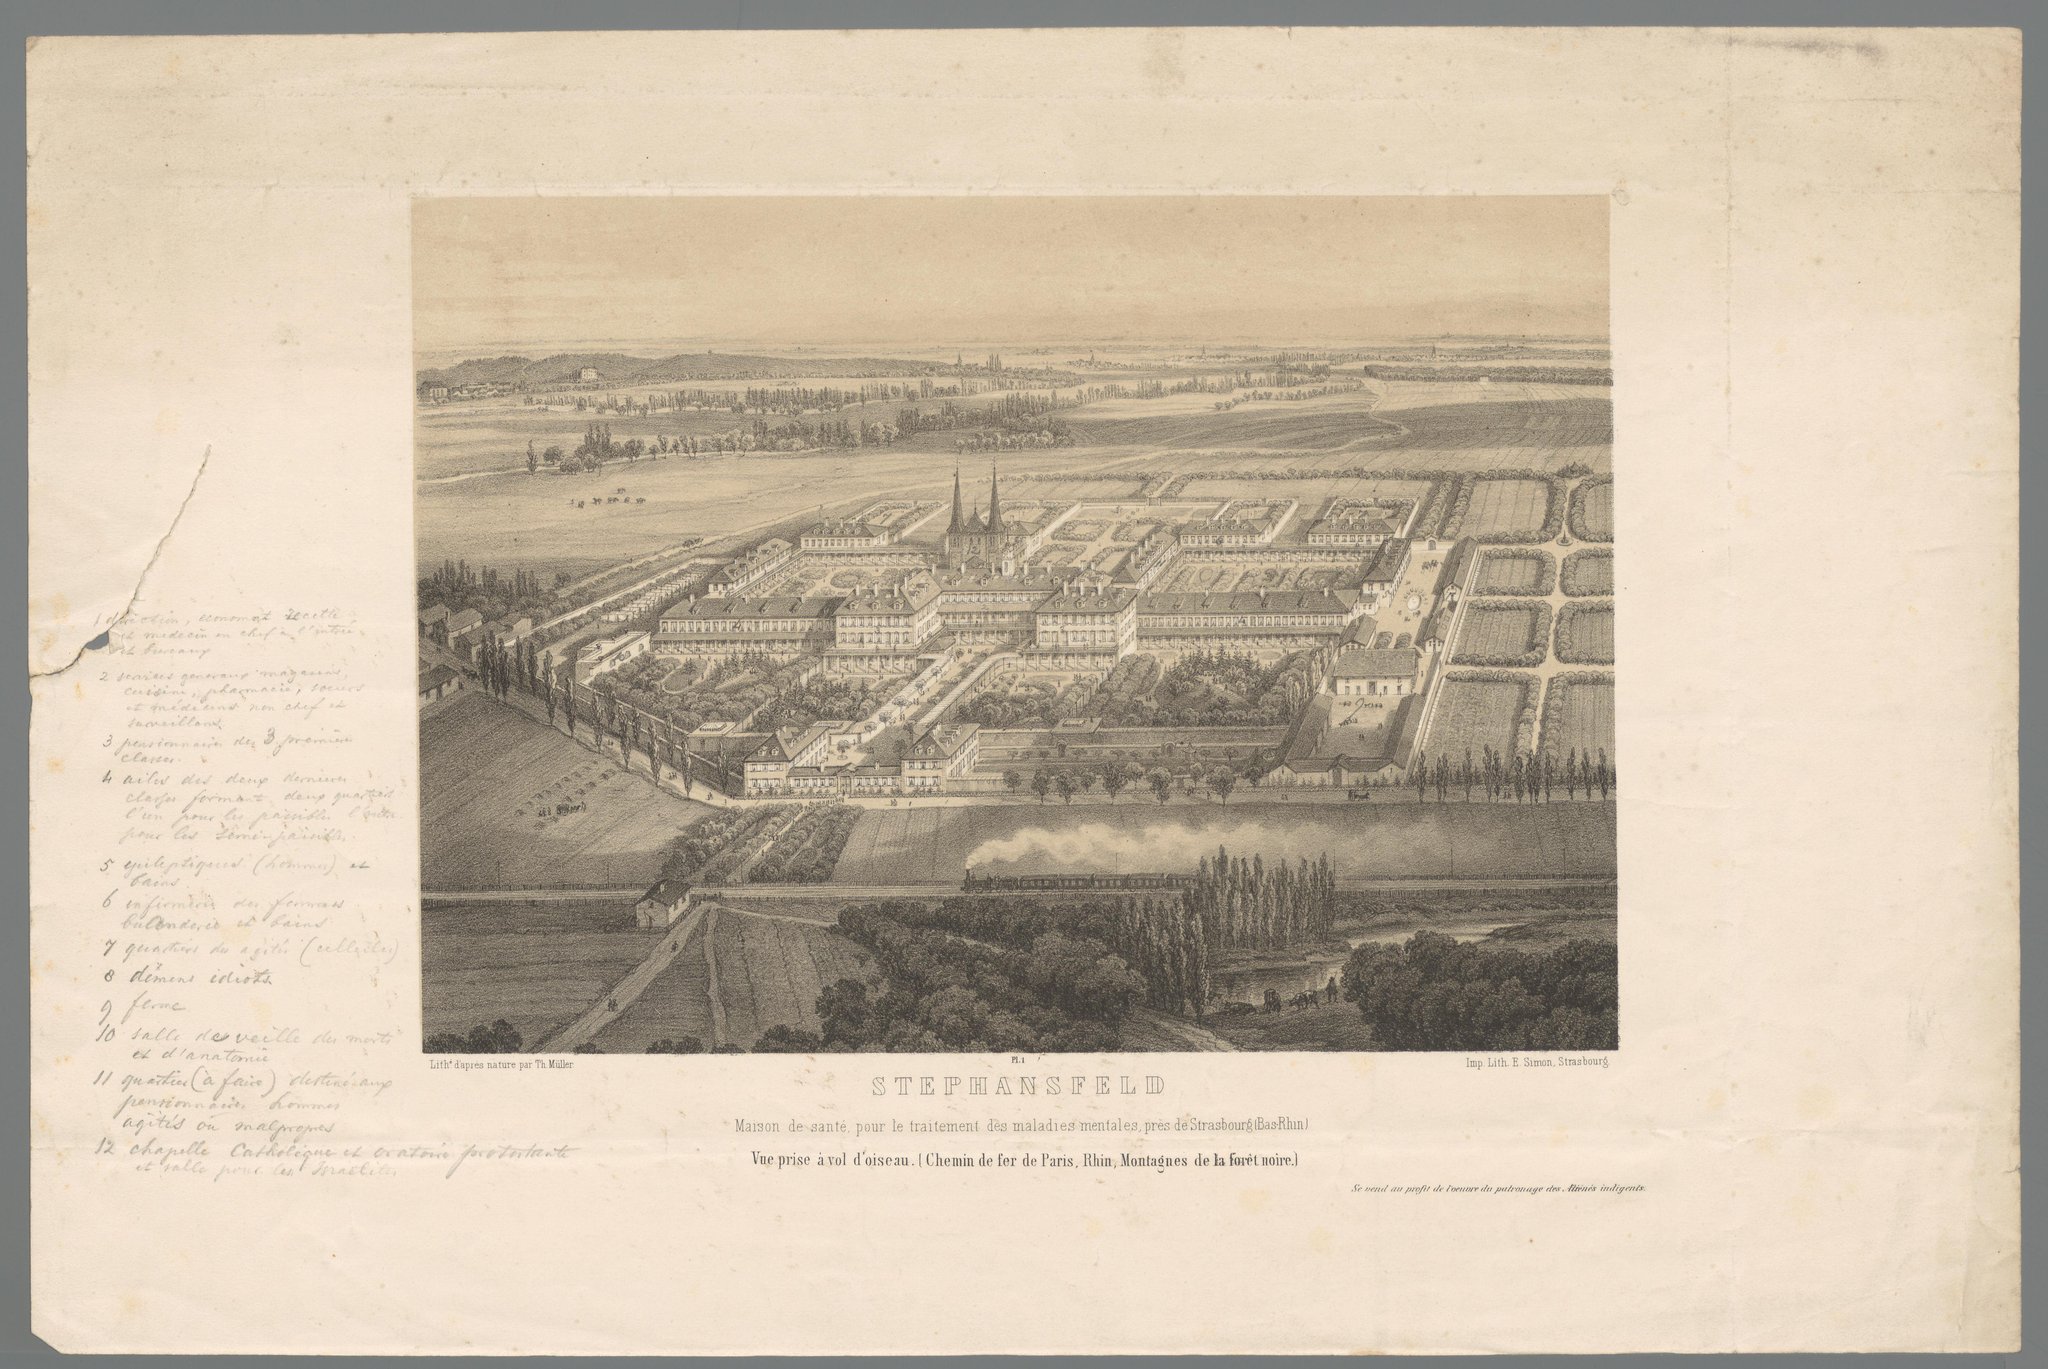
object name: print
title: Gezicht op het psychiatrisch ziekenhuis nabij Straatsburg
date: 1829-1879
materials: paper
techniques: tone lithography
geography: straatsburg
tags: hospital, landscapes in the temperate zone (+ landscape with figures, staffage)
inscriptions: collector's mark: Lugt 2228